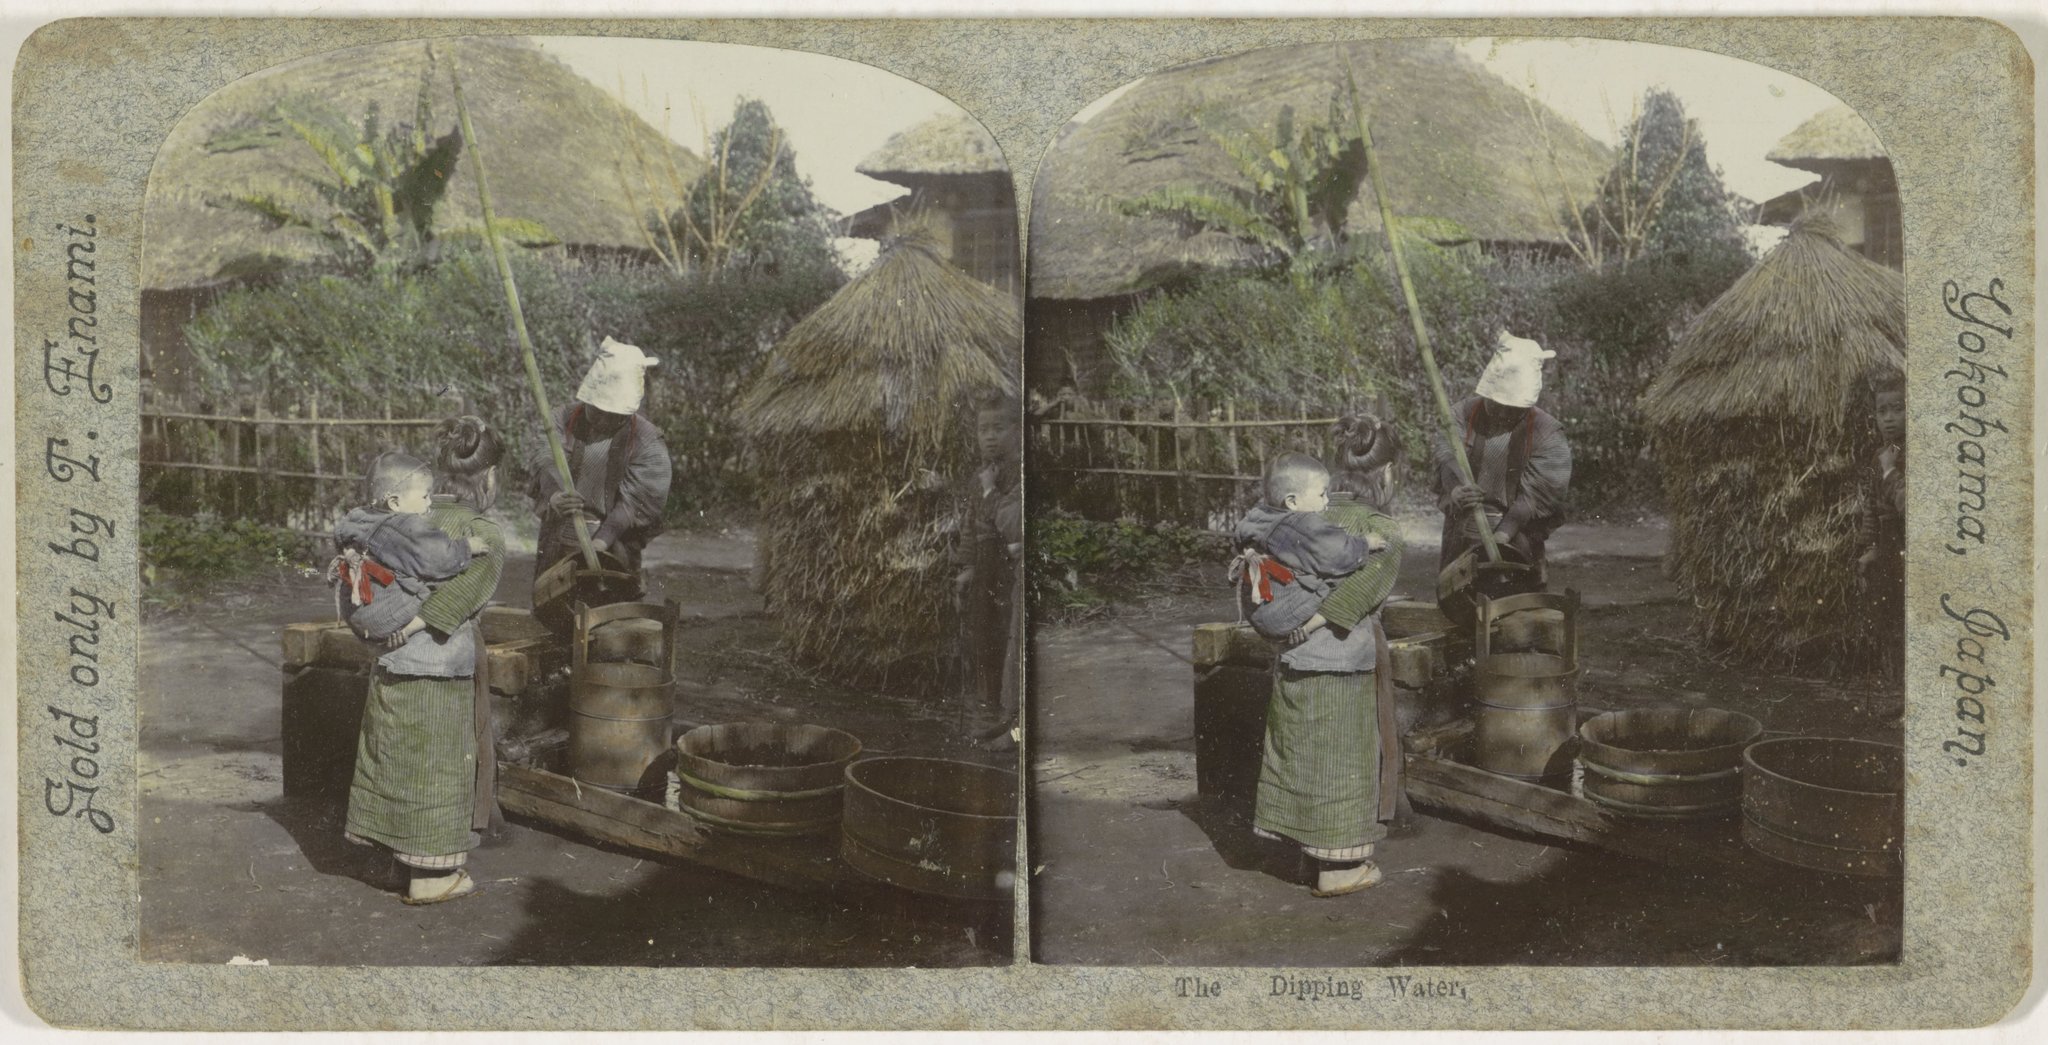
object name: stereograph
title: Man, vrouw en kind halen water bij een waterput, Japan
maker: t. enami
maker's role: publisher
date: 1900-1907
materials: paper, cardboard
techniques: hand coloring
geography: yokohama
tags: well, japan